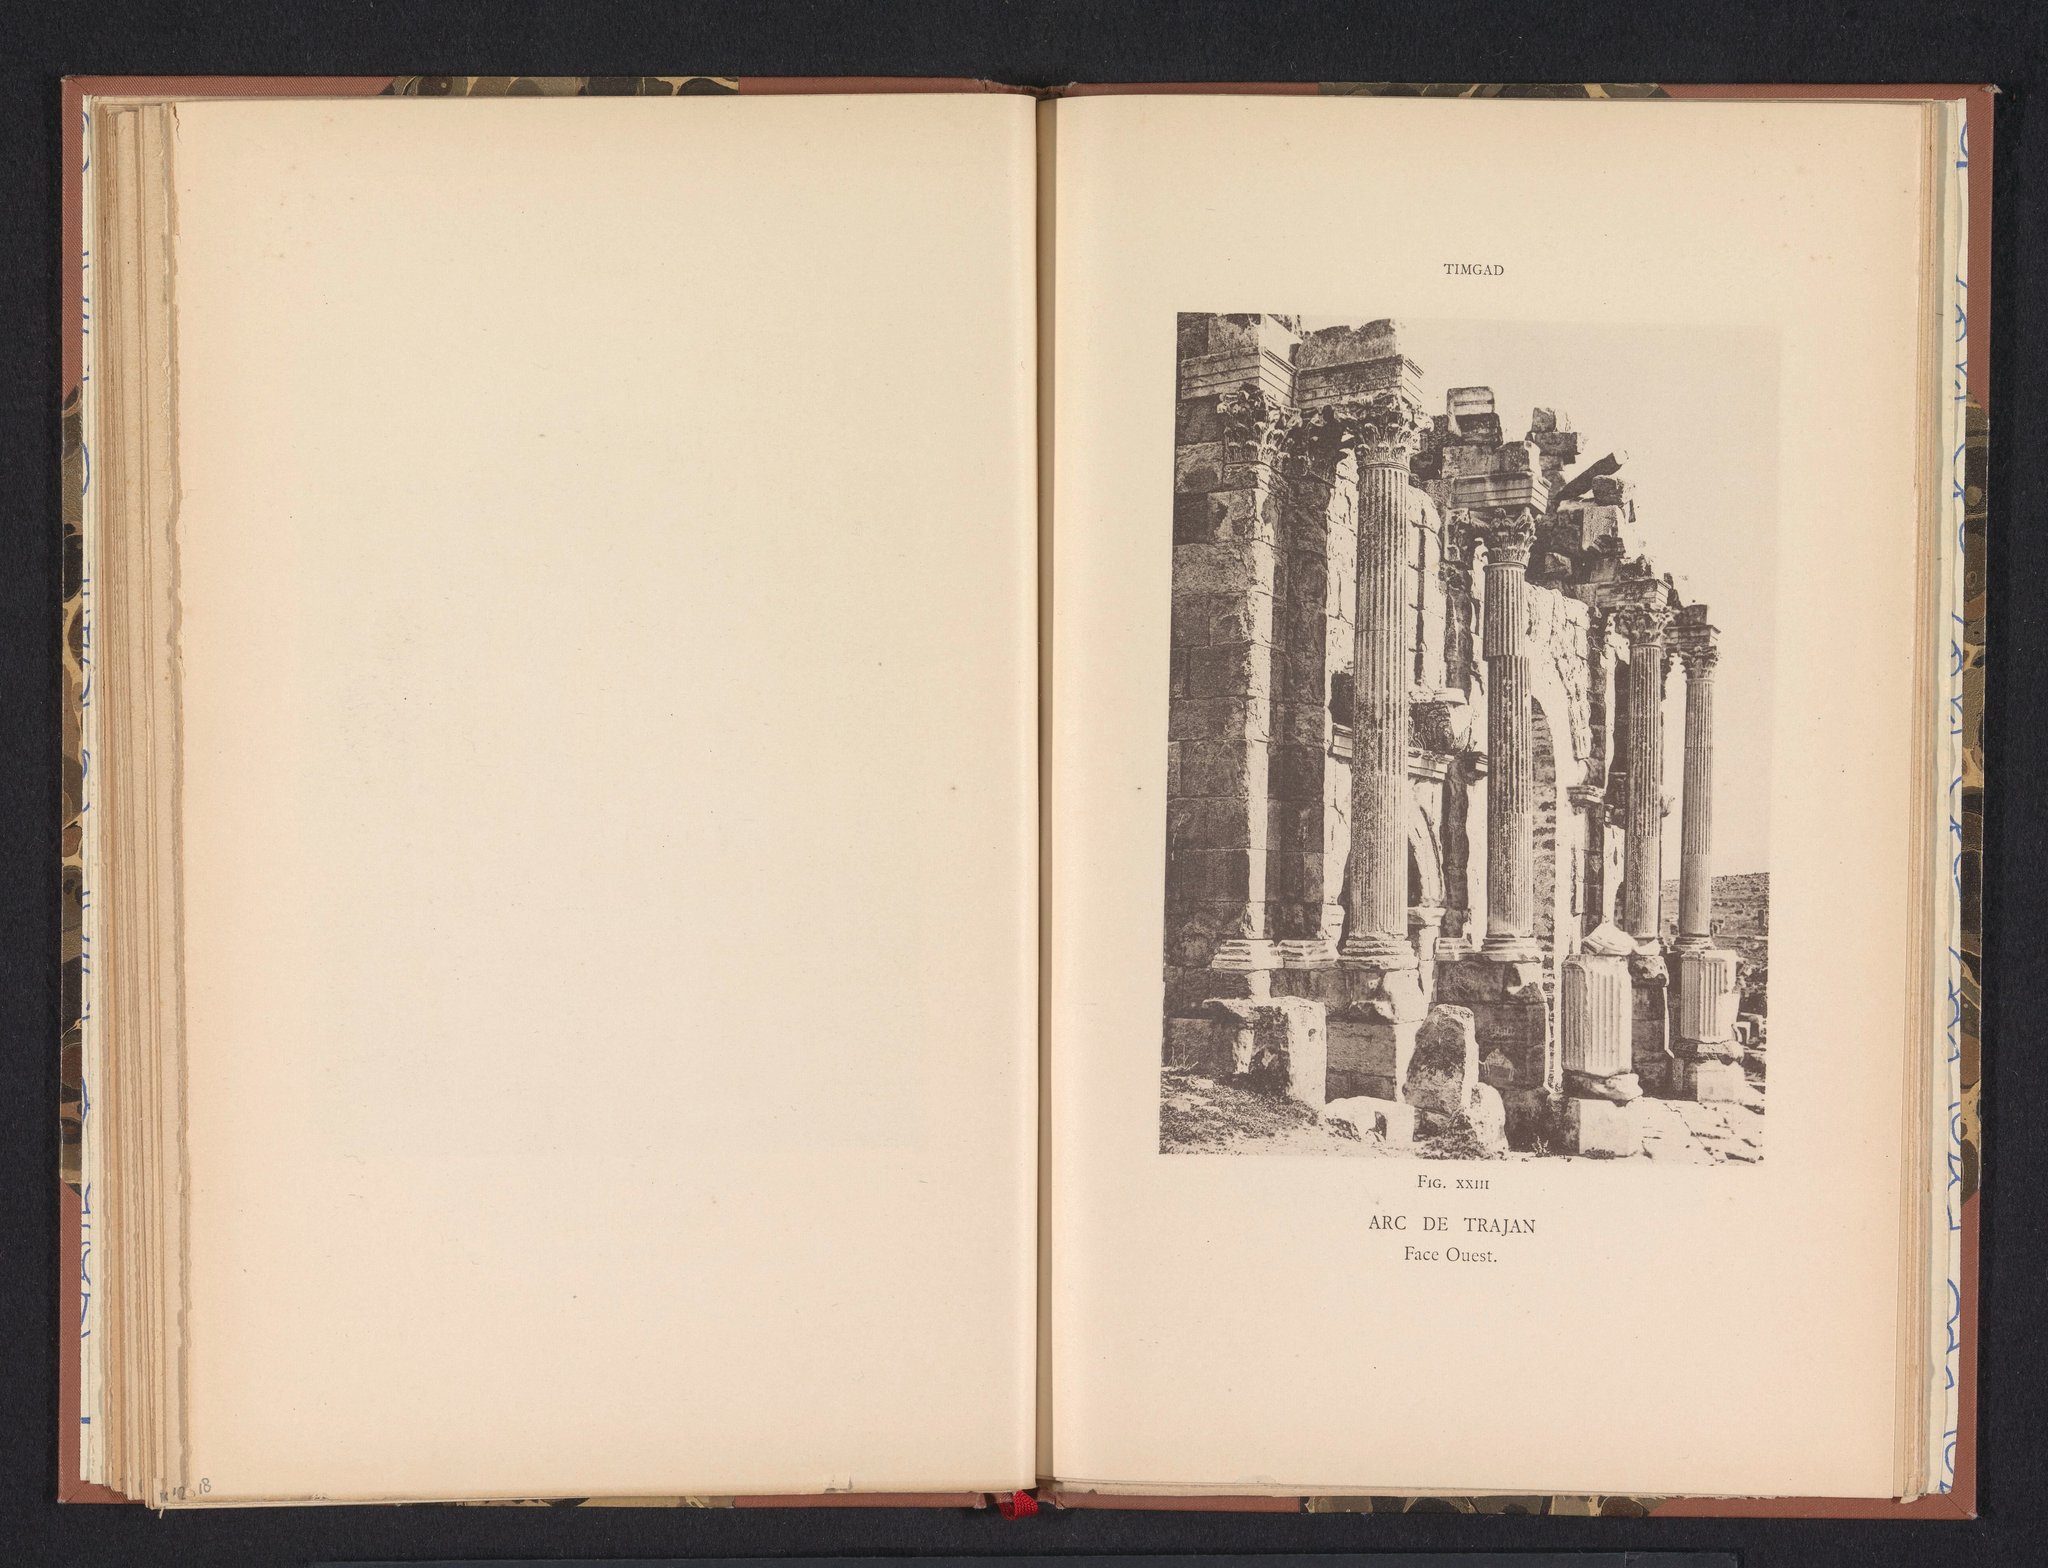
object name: page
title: Arc de Trajan Face Ouest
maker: Anonymous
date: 1884-1894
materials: paper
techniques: photograph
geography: timgad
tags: triumphal arch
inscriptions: number: ‘Fig. XXIII’